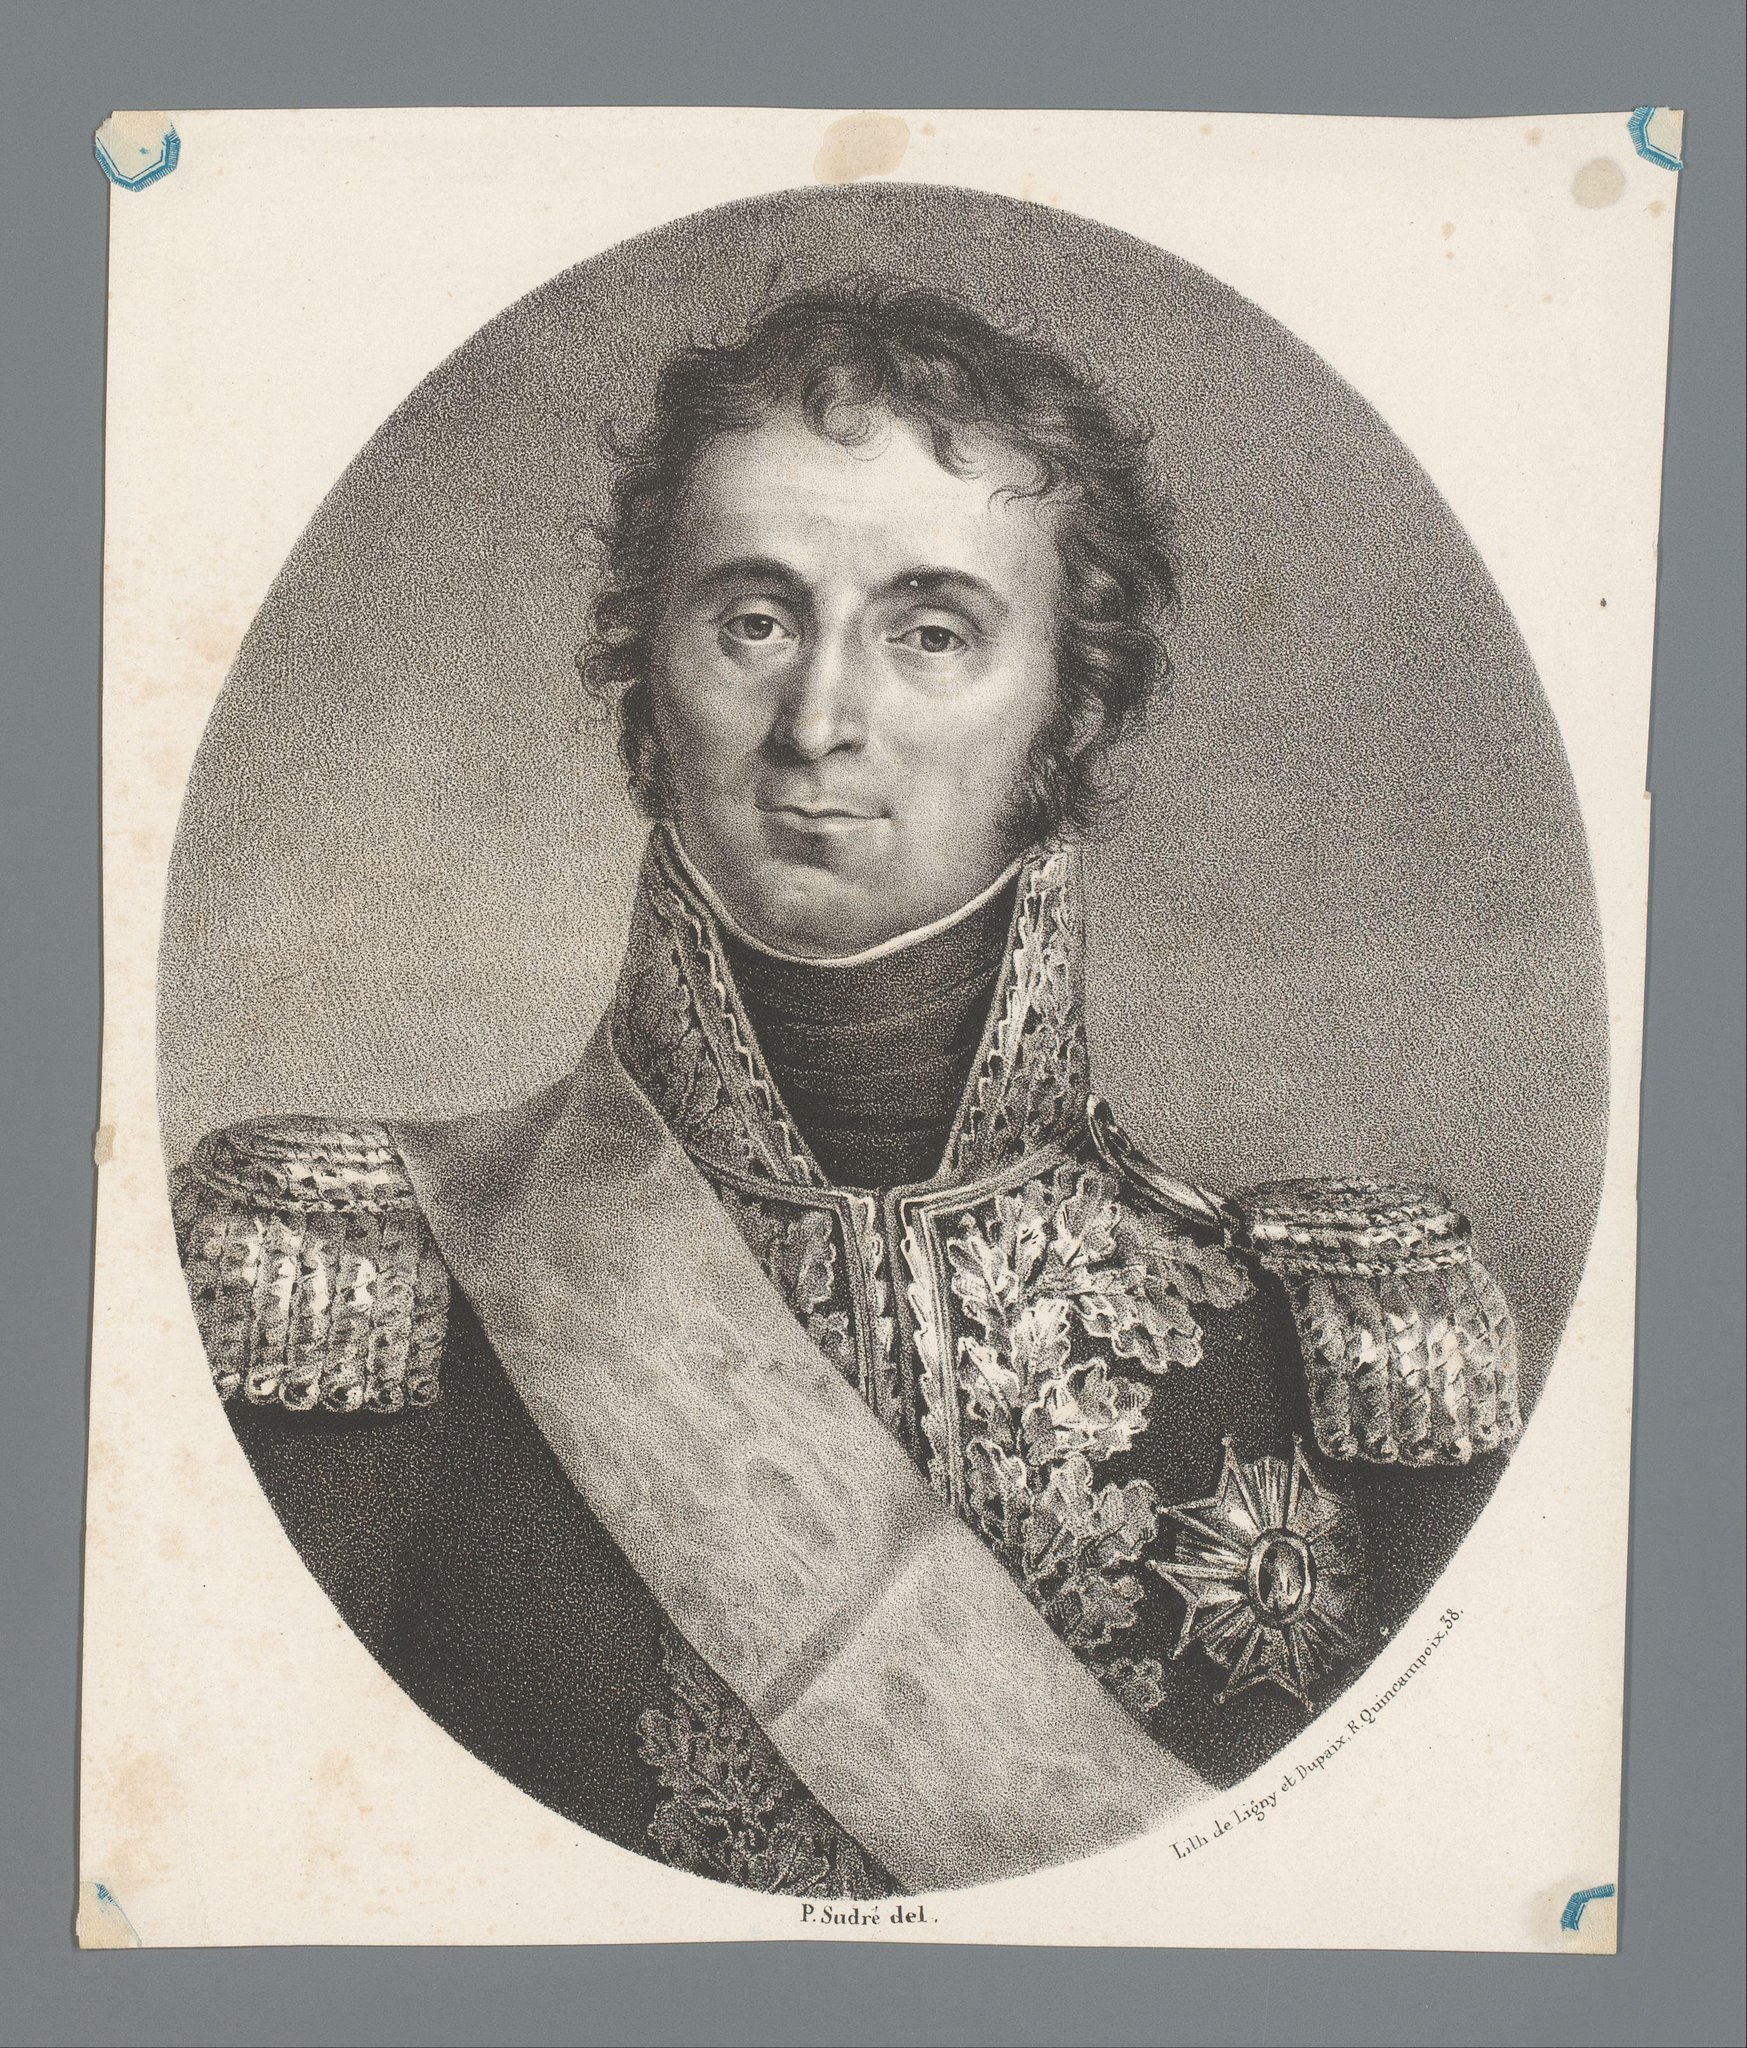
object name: print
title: Portretten van Franse beroemdheden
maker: jean pierre sudre (1783-1866)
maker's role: painter, print maker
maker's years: 1783-1866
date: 1826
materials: paper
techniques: lithograph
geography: paris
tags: historical persons